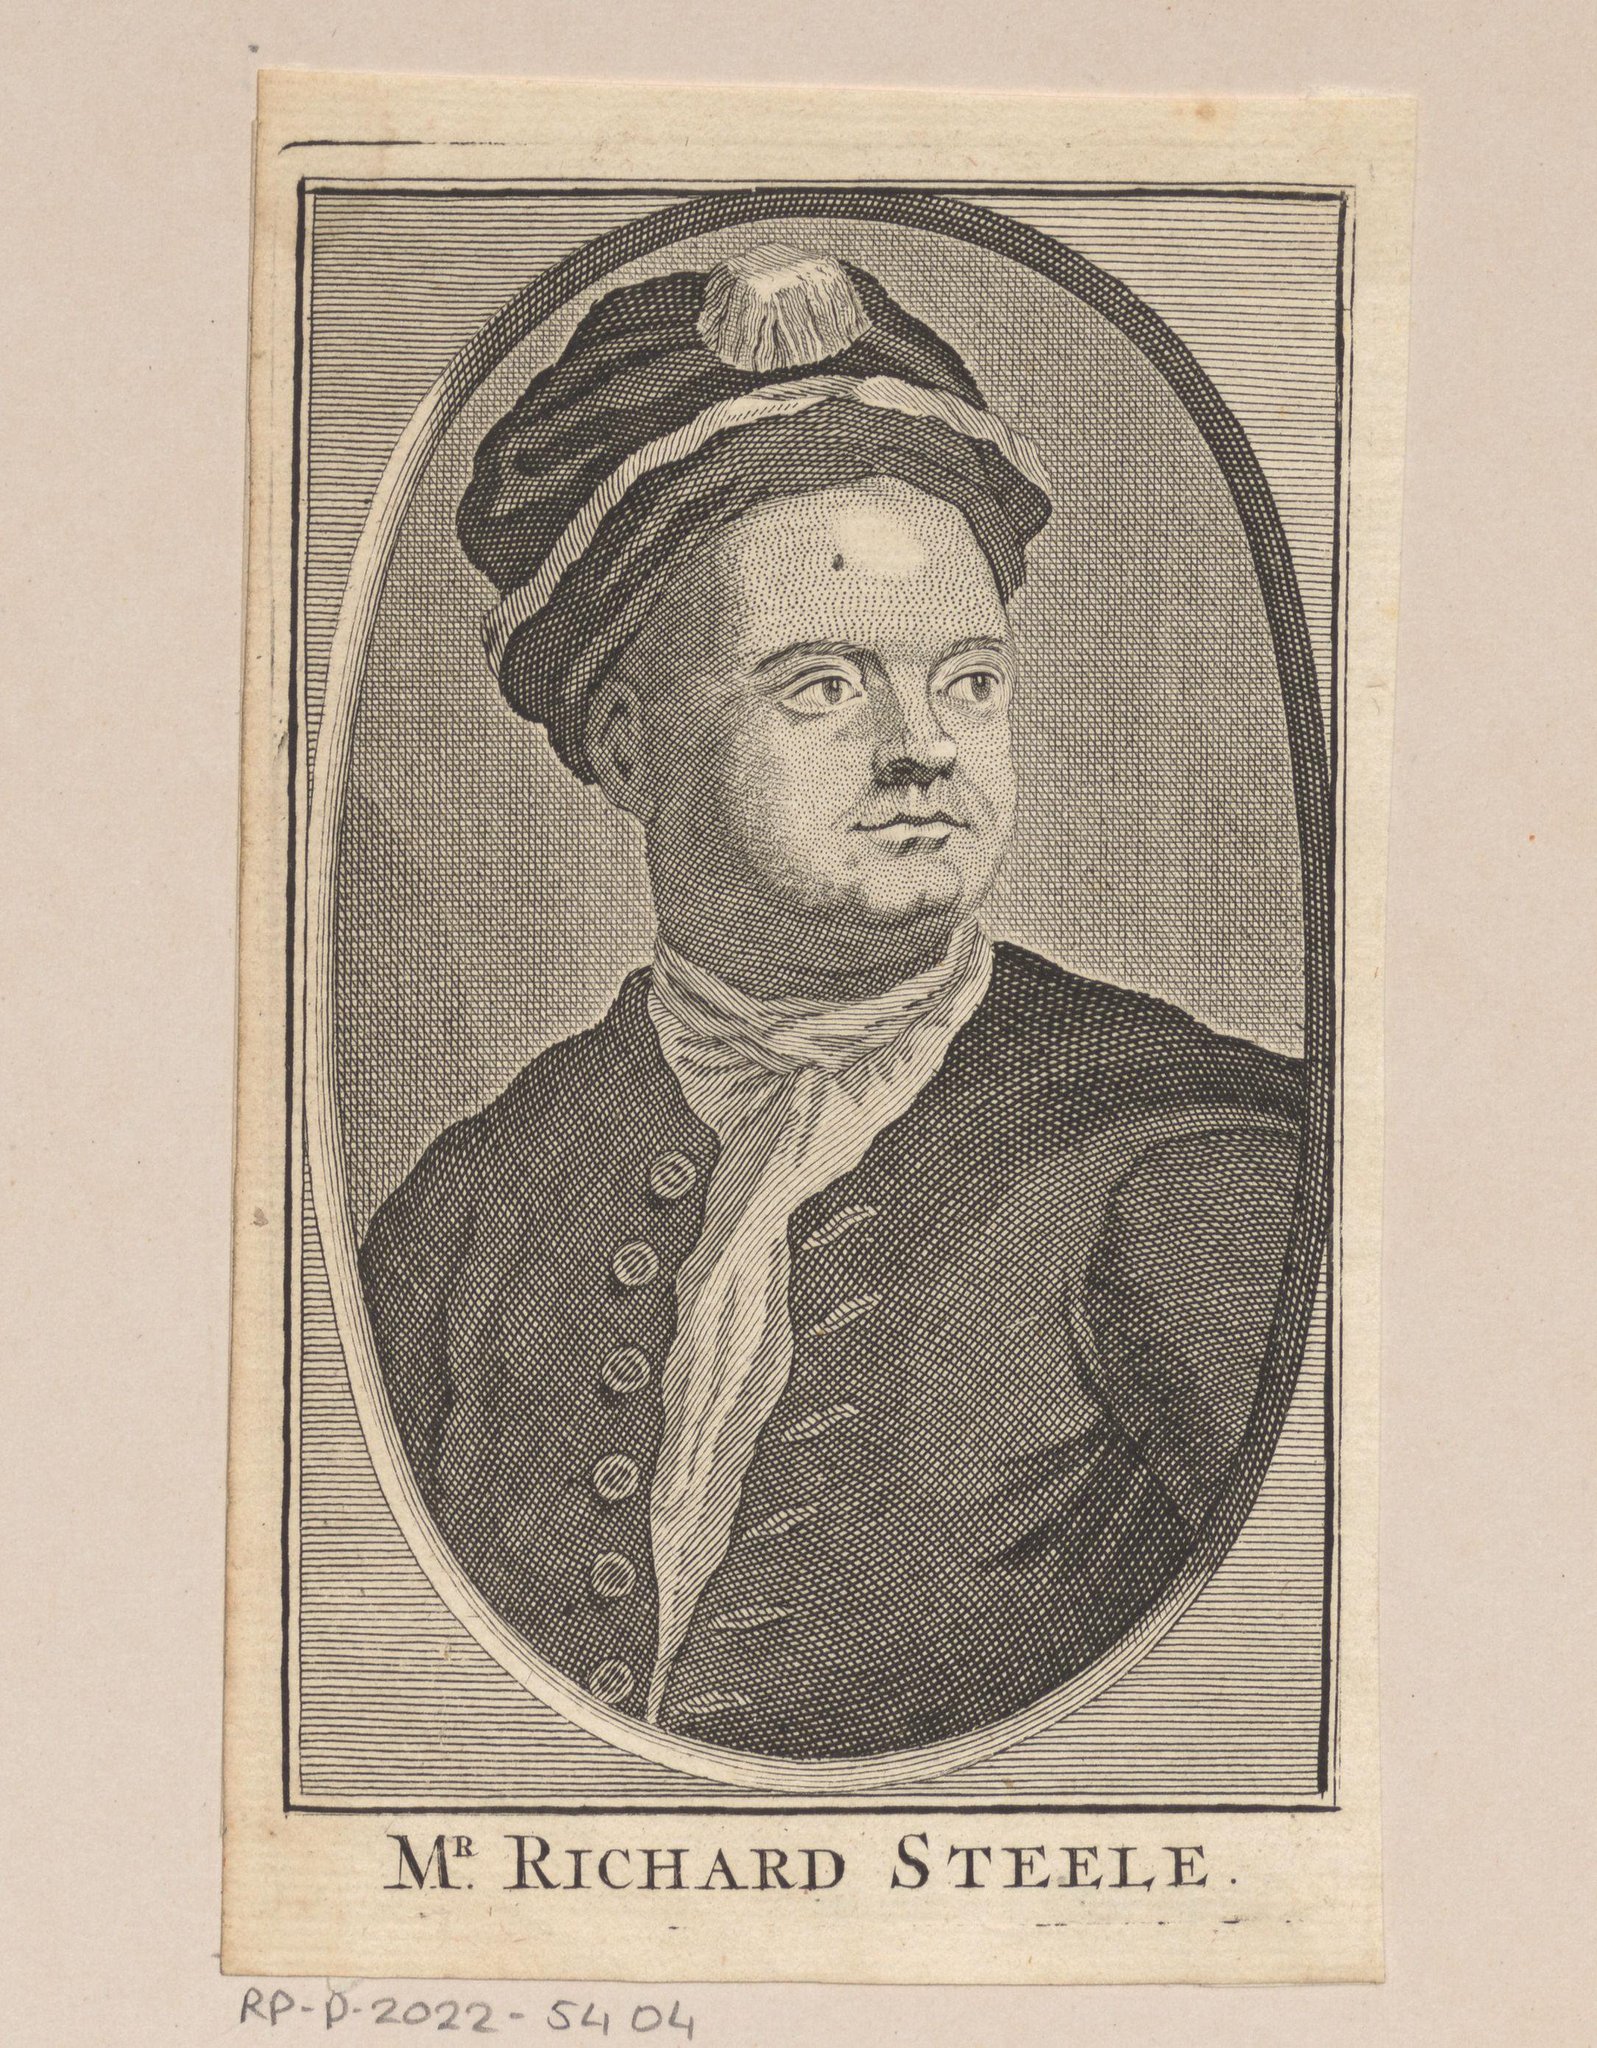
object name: print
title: Portret van Richard Steele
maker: Anonymous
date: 1701-1799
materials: paper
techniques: engraving, etching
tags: historical persons, portrait of a writer, politician, e.g. party leader